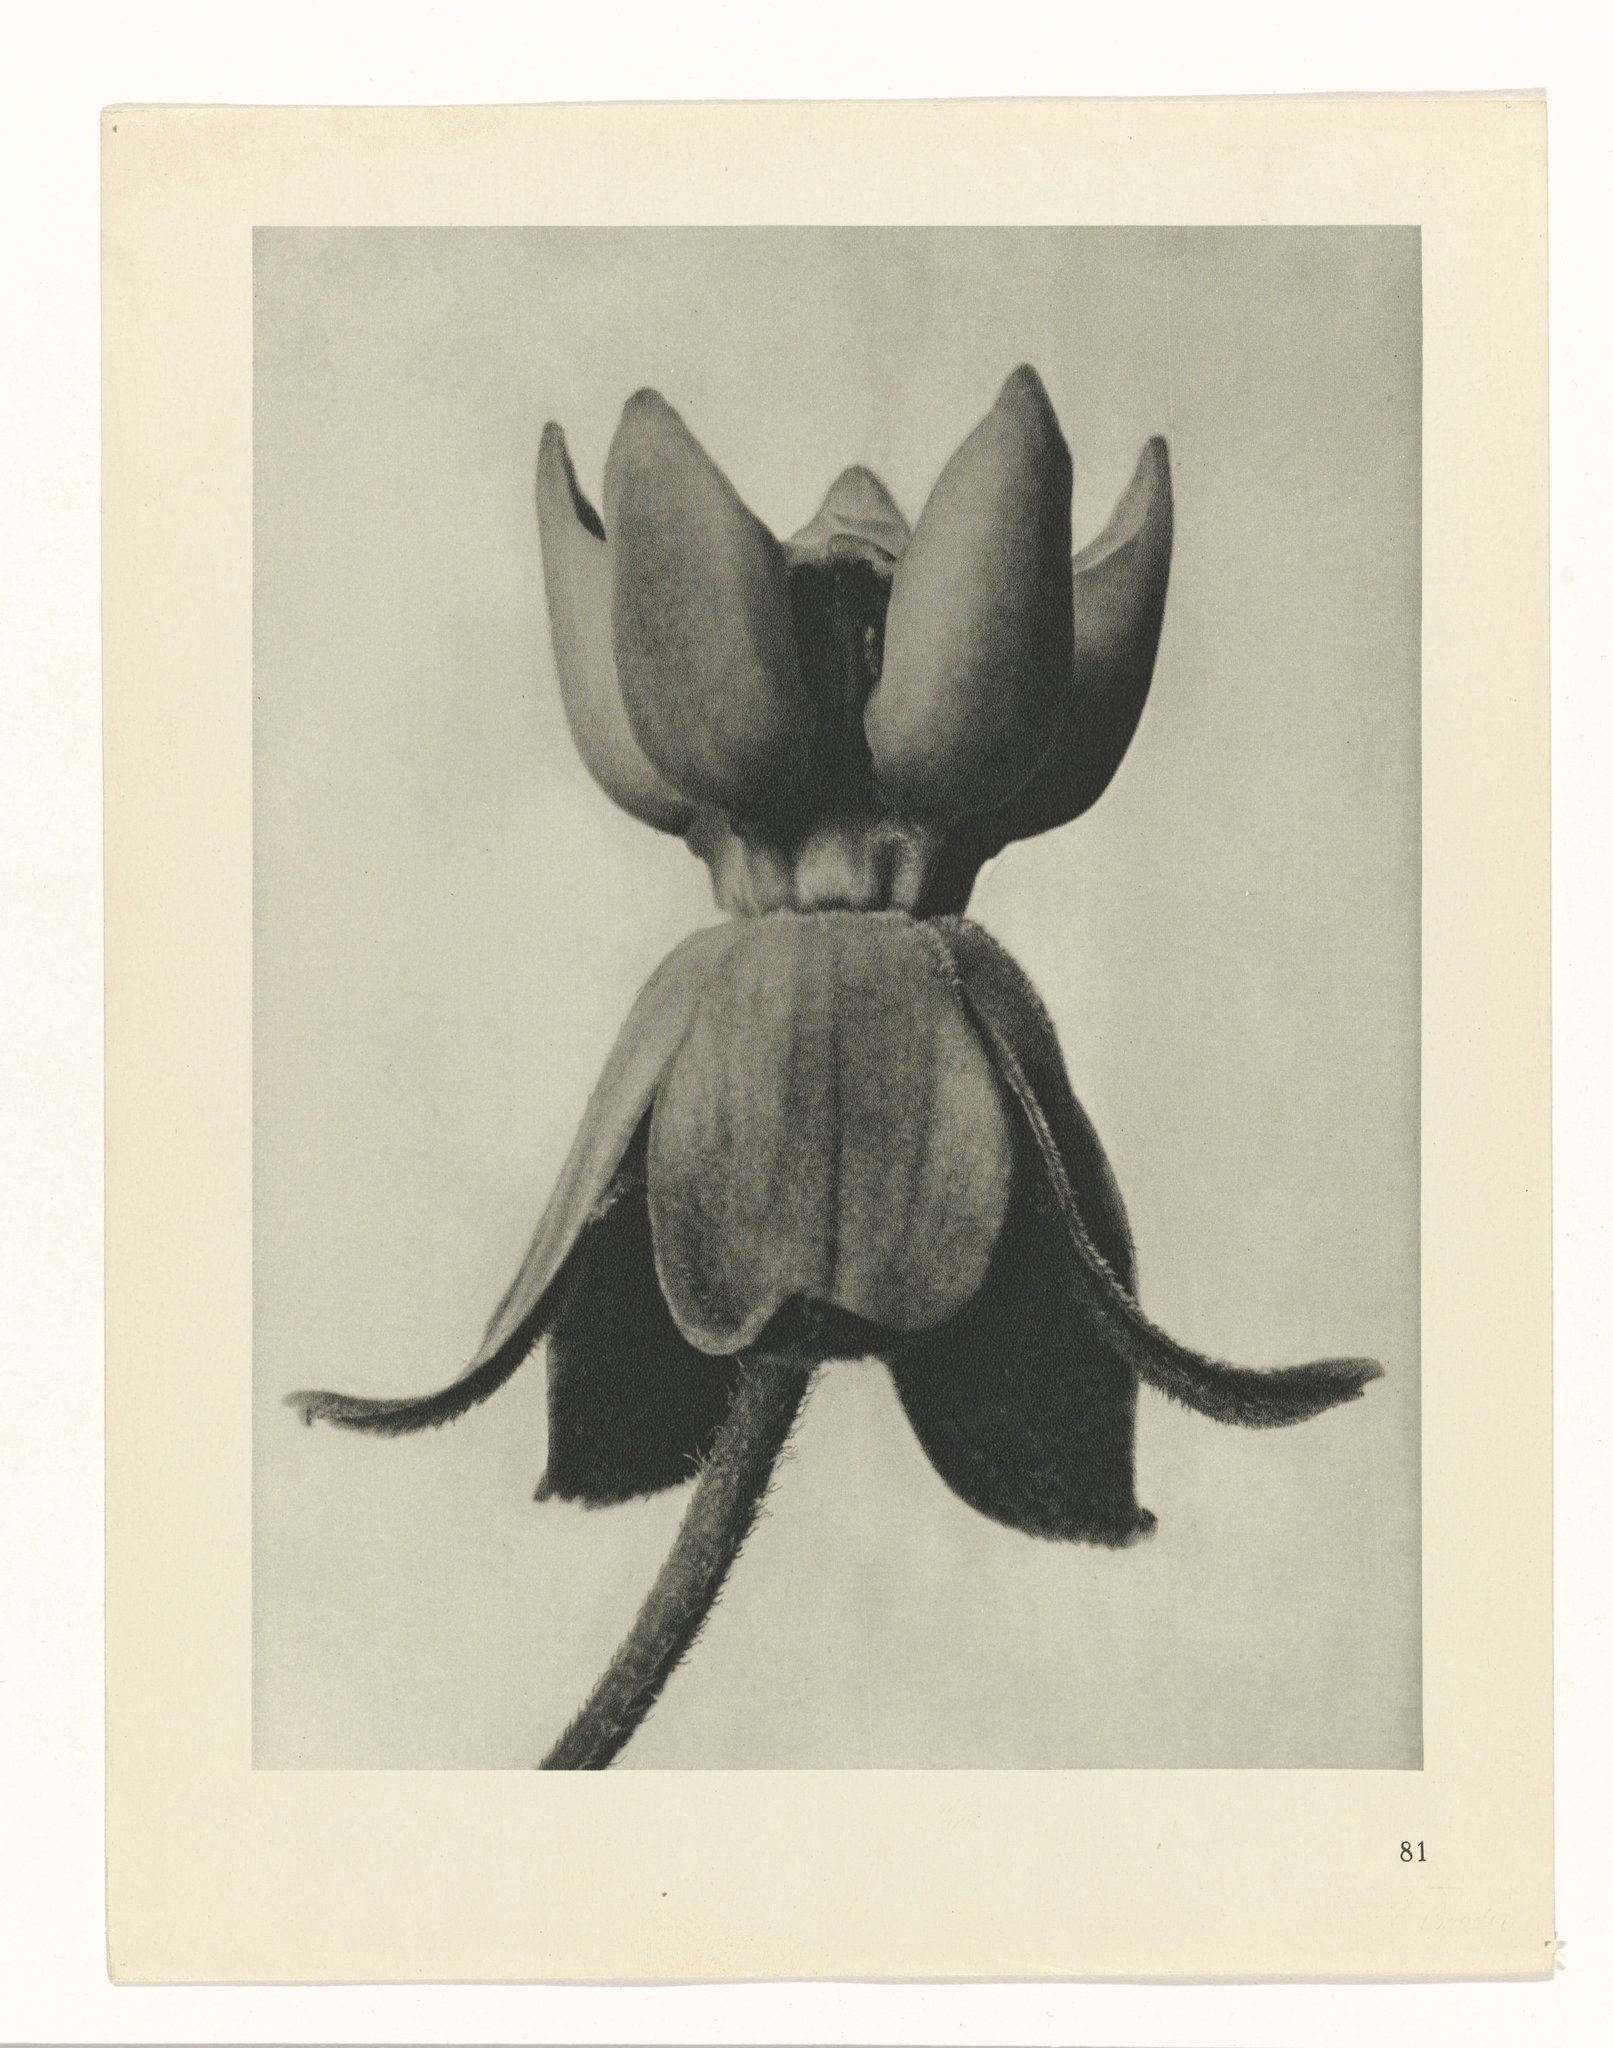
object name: photograph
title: Plantstudie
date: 1928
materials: ink, paper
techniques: rotogravure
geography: berlin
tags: plants (in general)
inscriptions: number: ‘81’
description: facher Vergrößerung. Afkomstig uit losbladige uitgave.